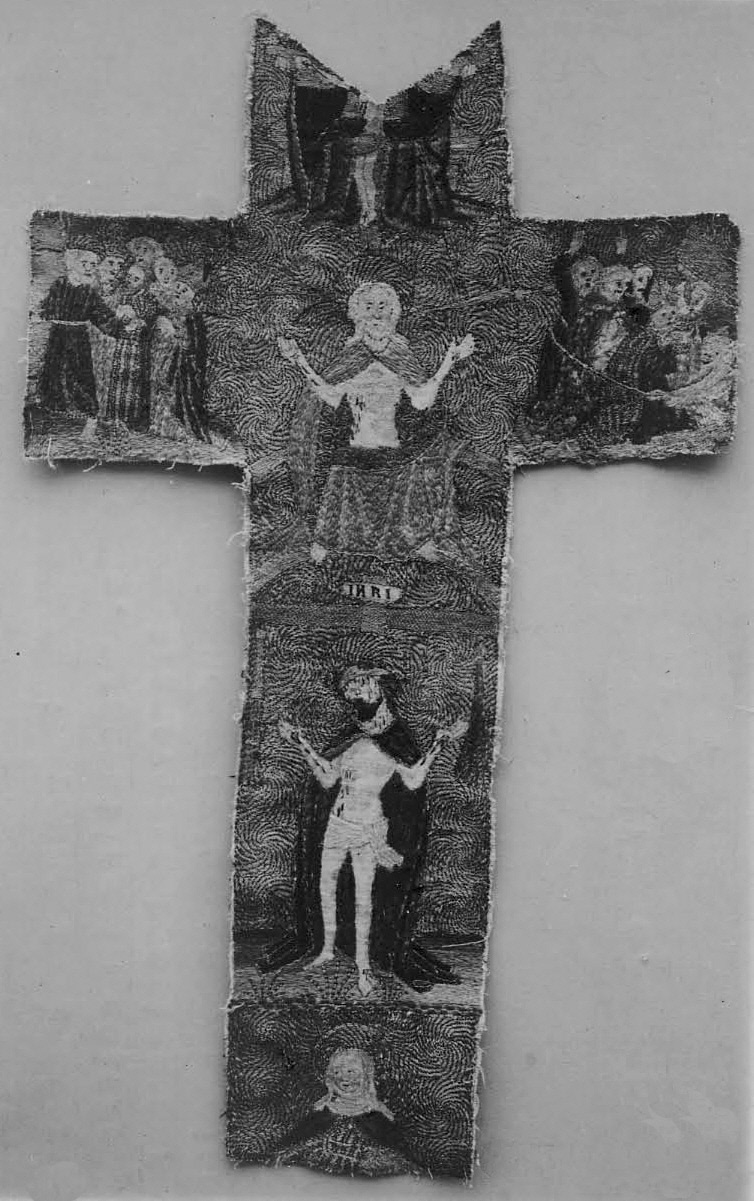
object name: orphrey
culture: german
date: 1601-1633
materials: metal thread, silk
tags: jesus,god the father